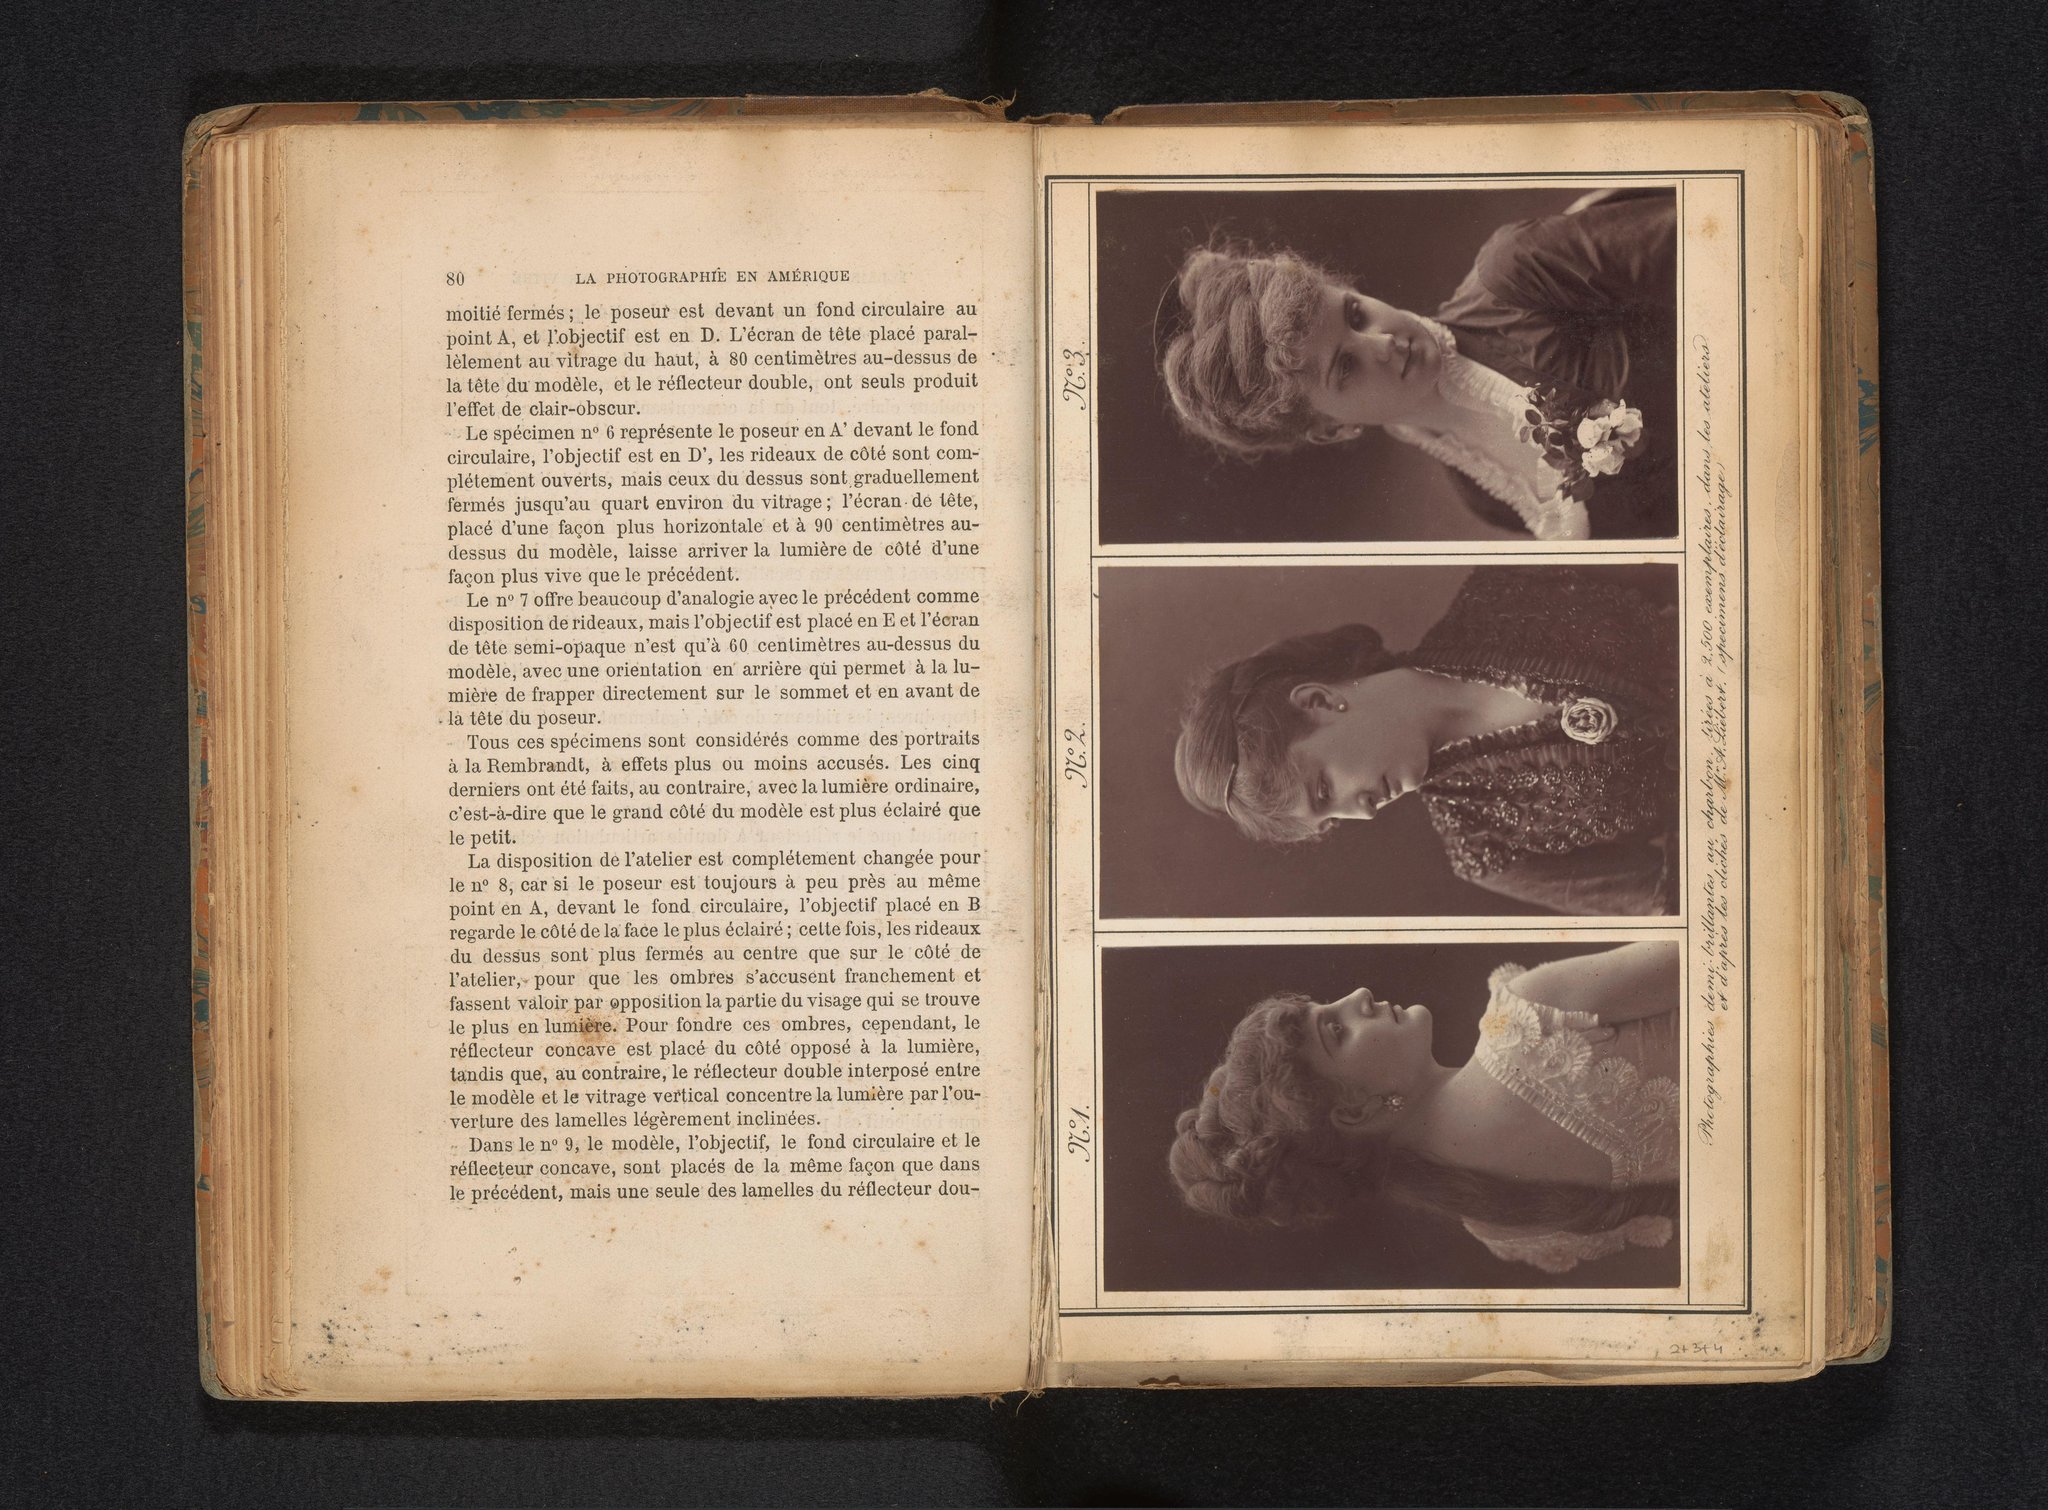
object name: page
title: Belichtingsstudie, afgebeeld een portret van een onbekende vrouw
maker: alphonse-justin liébert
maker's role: fotograaf, marinier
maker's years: 1827-1914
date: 1873-1878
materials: paper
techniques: carbon print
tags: historical persons not known by name - bb - woman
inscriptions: inscription: ‘Photographies demi-brillantes au charbon, tirées à 2.500 exemplaires, dans les ateliers/ et d'après les clichés de Mr. A. Liébert. (specimens d'éclairage)’, number: ‘No. 1.’